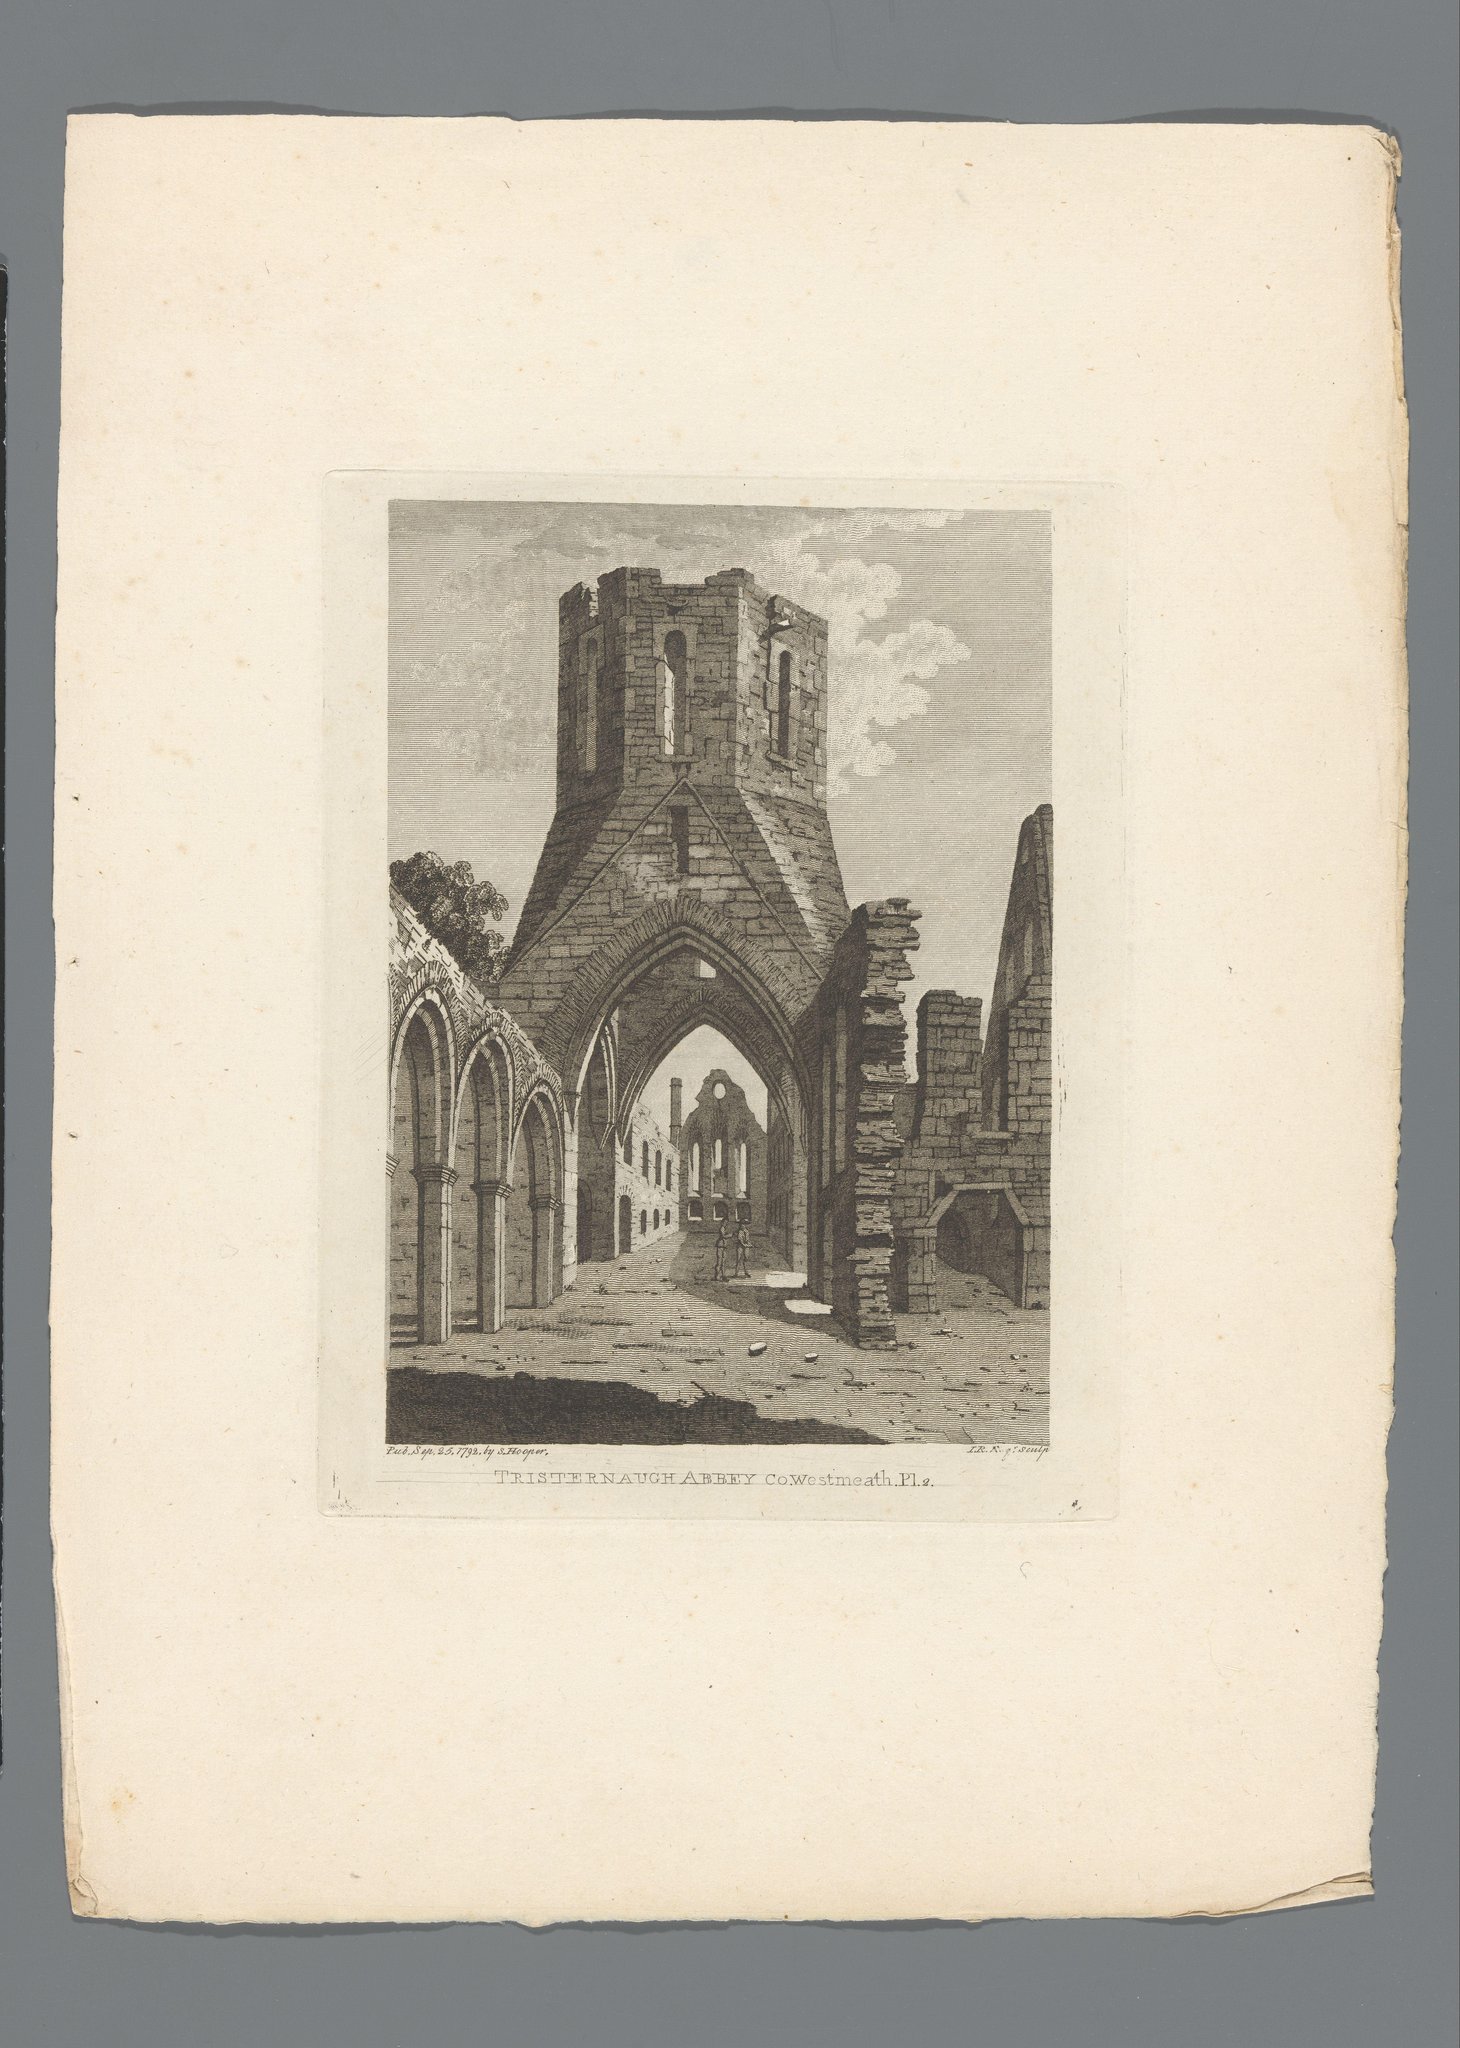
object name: print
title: Gezicht op de ruïnes van de abdij van Tristernagh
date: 1792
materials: paper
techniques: etching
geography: london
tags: landscape with ruins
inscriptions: mark: ‘IR. E sq sculp.’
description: Prent verschenen in: Grose, Francis. The antiquities of Ireland. Londen: S. Hooper, 1795, dl. 2.